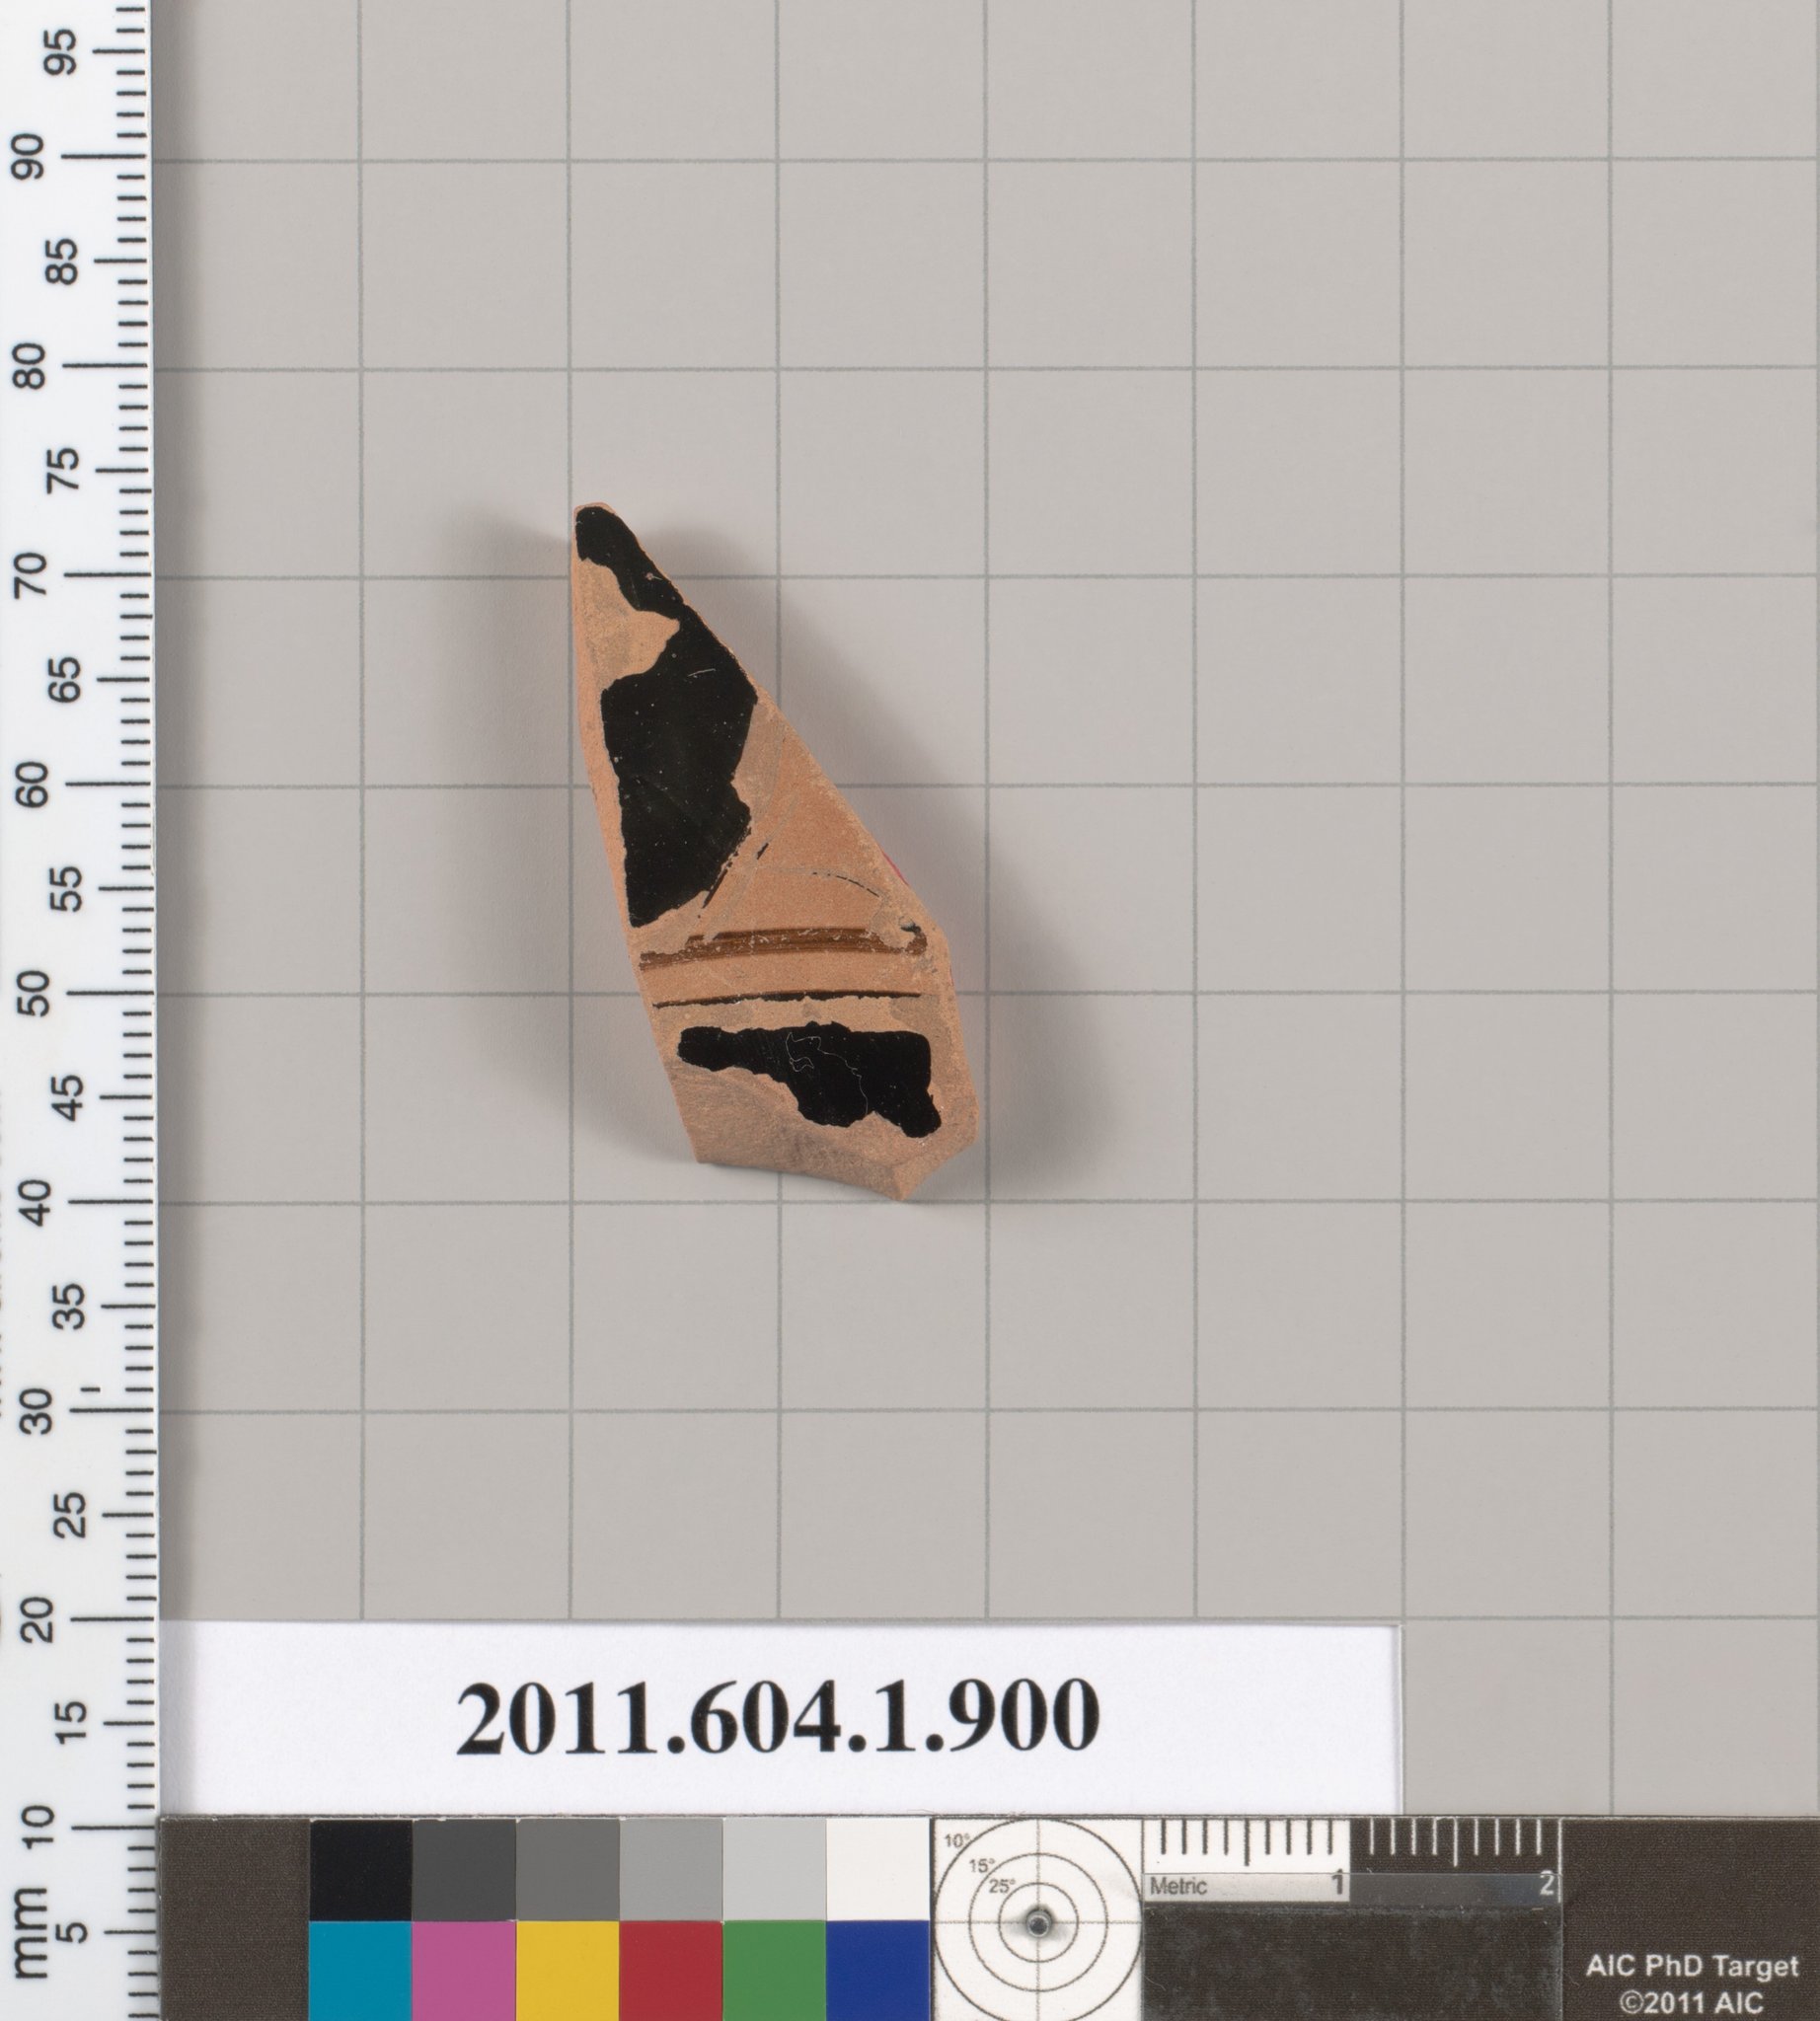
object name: kylix fragment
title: Terracotta fragment of a kylix (drinking cup)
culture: greek, attic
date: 475-451 BCE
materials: terracotta